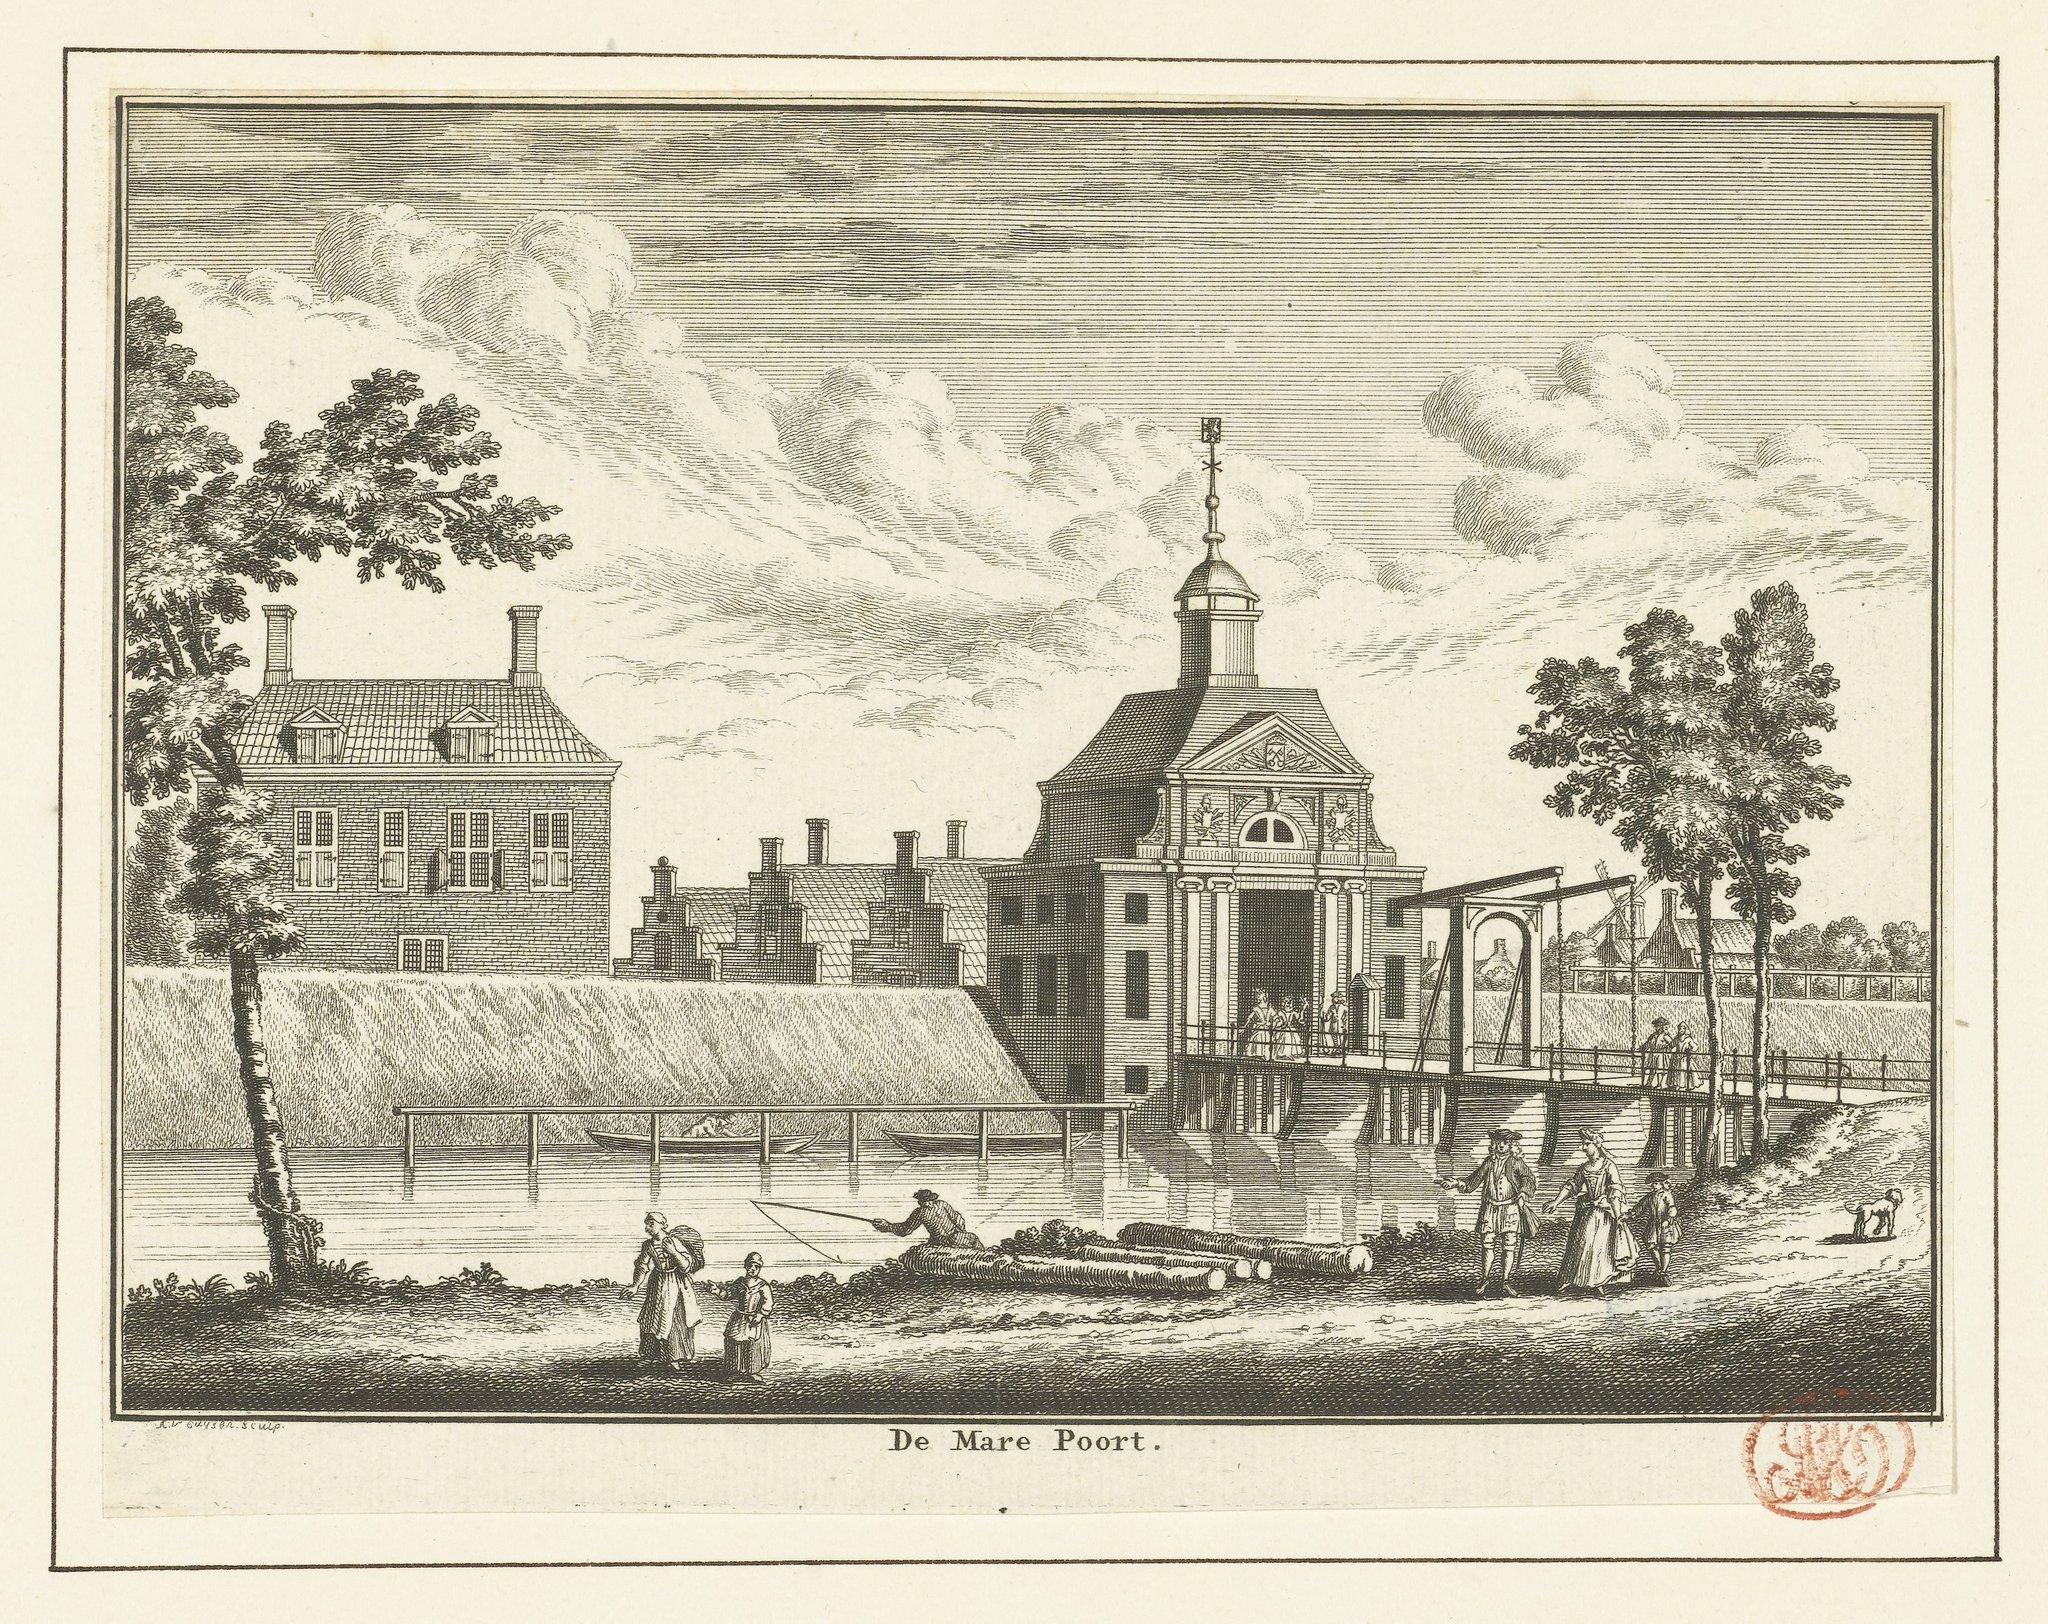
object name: print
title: De Mare Poort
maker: andries van buysen (sr.)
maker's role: print maker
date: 1734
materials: paper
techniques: engraving, etching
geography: amsterdam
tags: bridge, city-gate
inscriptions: collector's mark: Lugt 2228, collector's mark: Lugt 195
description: Prent ook gebruikt in: De vermakelyke Leidsche buiten-cingels, aangenaame dorpen en landstreken, rondom die stad gelegen (…) versiert met alle de stadts-poorten. Leiden: Quirinum Visscher, Amsterdam: Arent van Huyssteen, 1734.